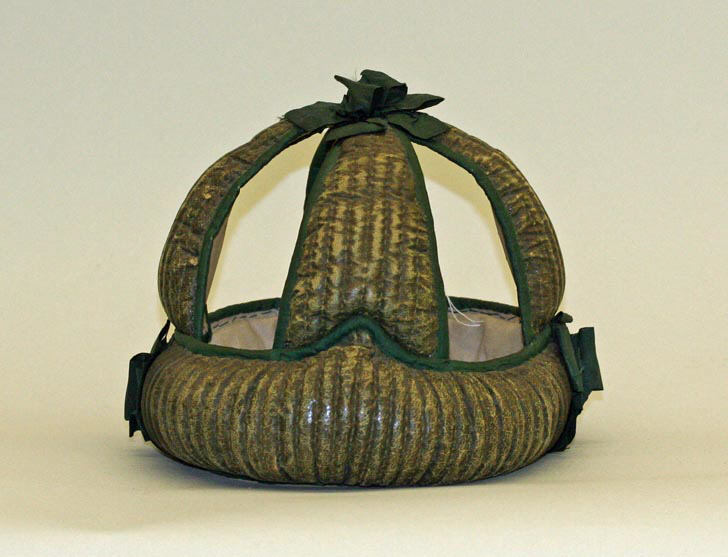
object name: head protector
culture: swiss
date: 1701-1800